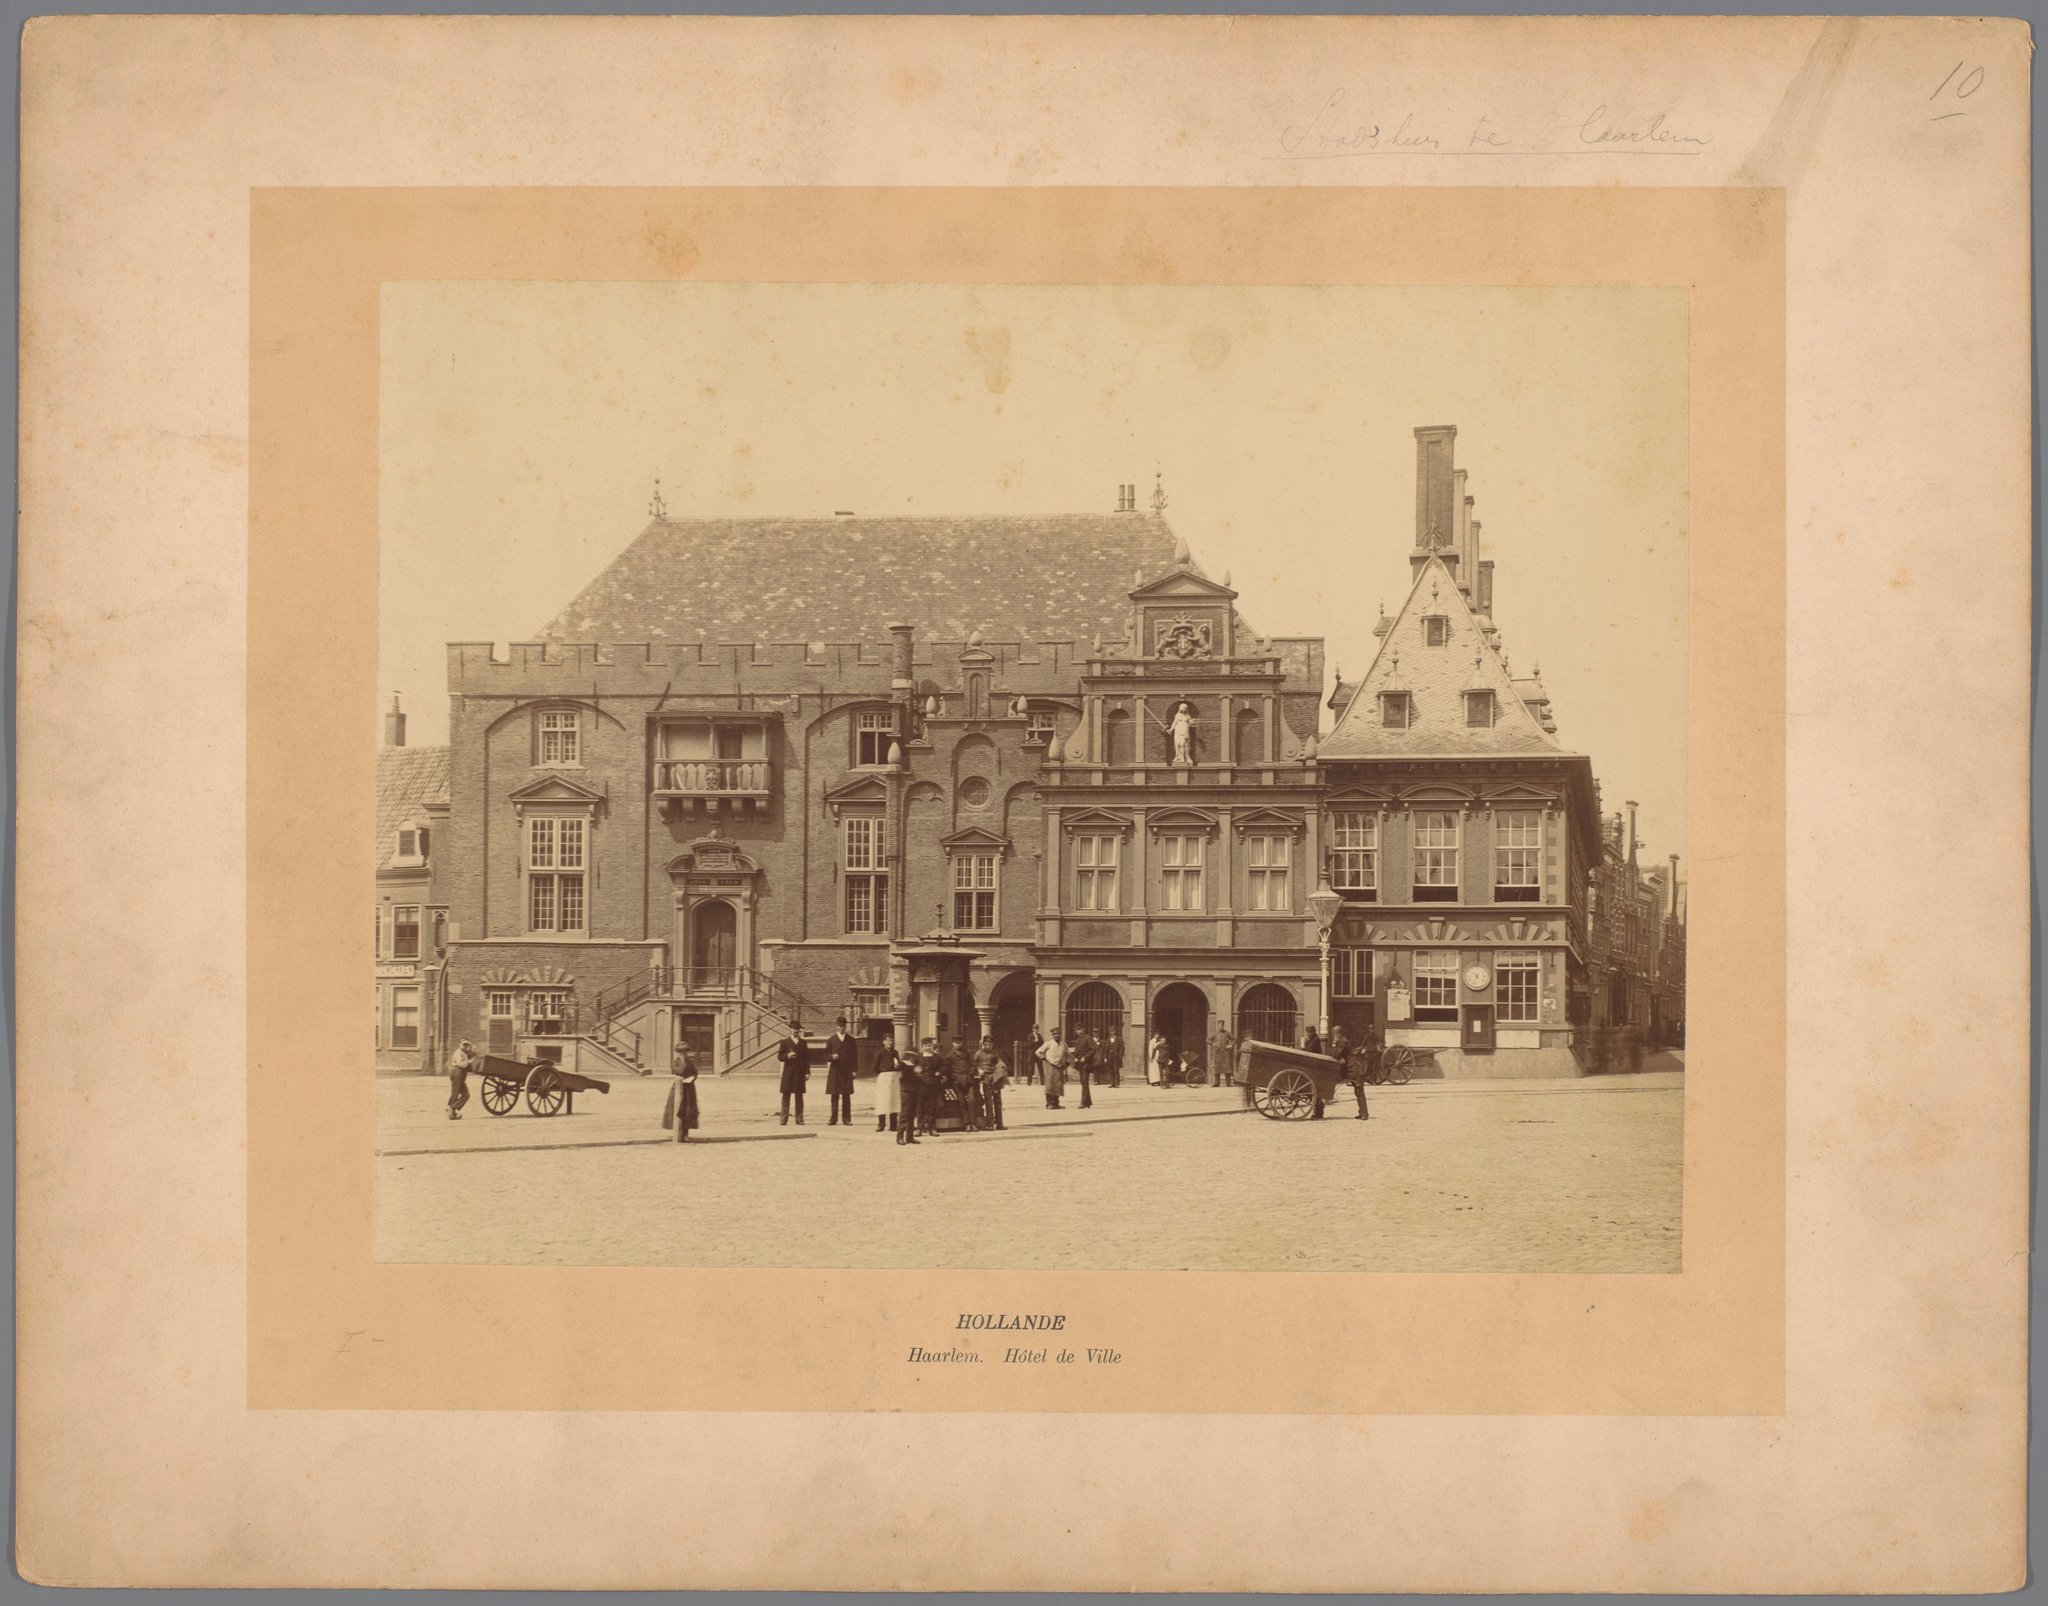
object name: photograph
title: Exterieur van het stadhuis van Haarlem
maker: Anonymous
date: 1875-1900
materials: cardboard, photographic support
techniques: albumen print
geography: haarlem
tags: townhall, façade (of house or building), village square, place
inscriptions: inscription: ‘Stadshuis te Haarlem’, collector's mark: Lugt 3937, inscription: ‘HOLLANDE Haarlem. Hôtel de Ville’